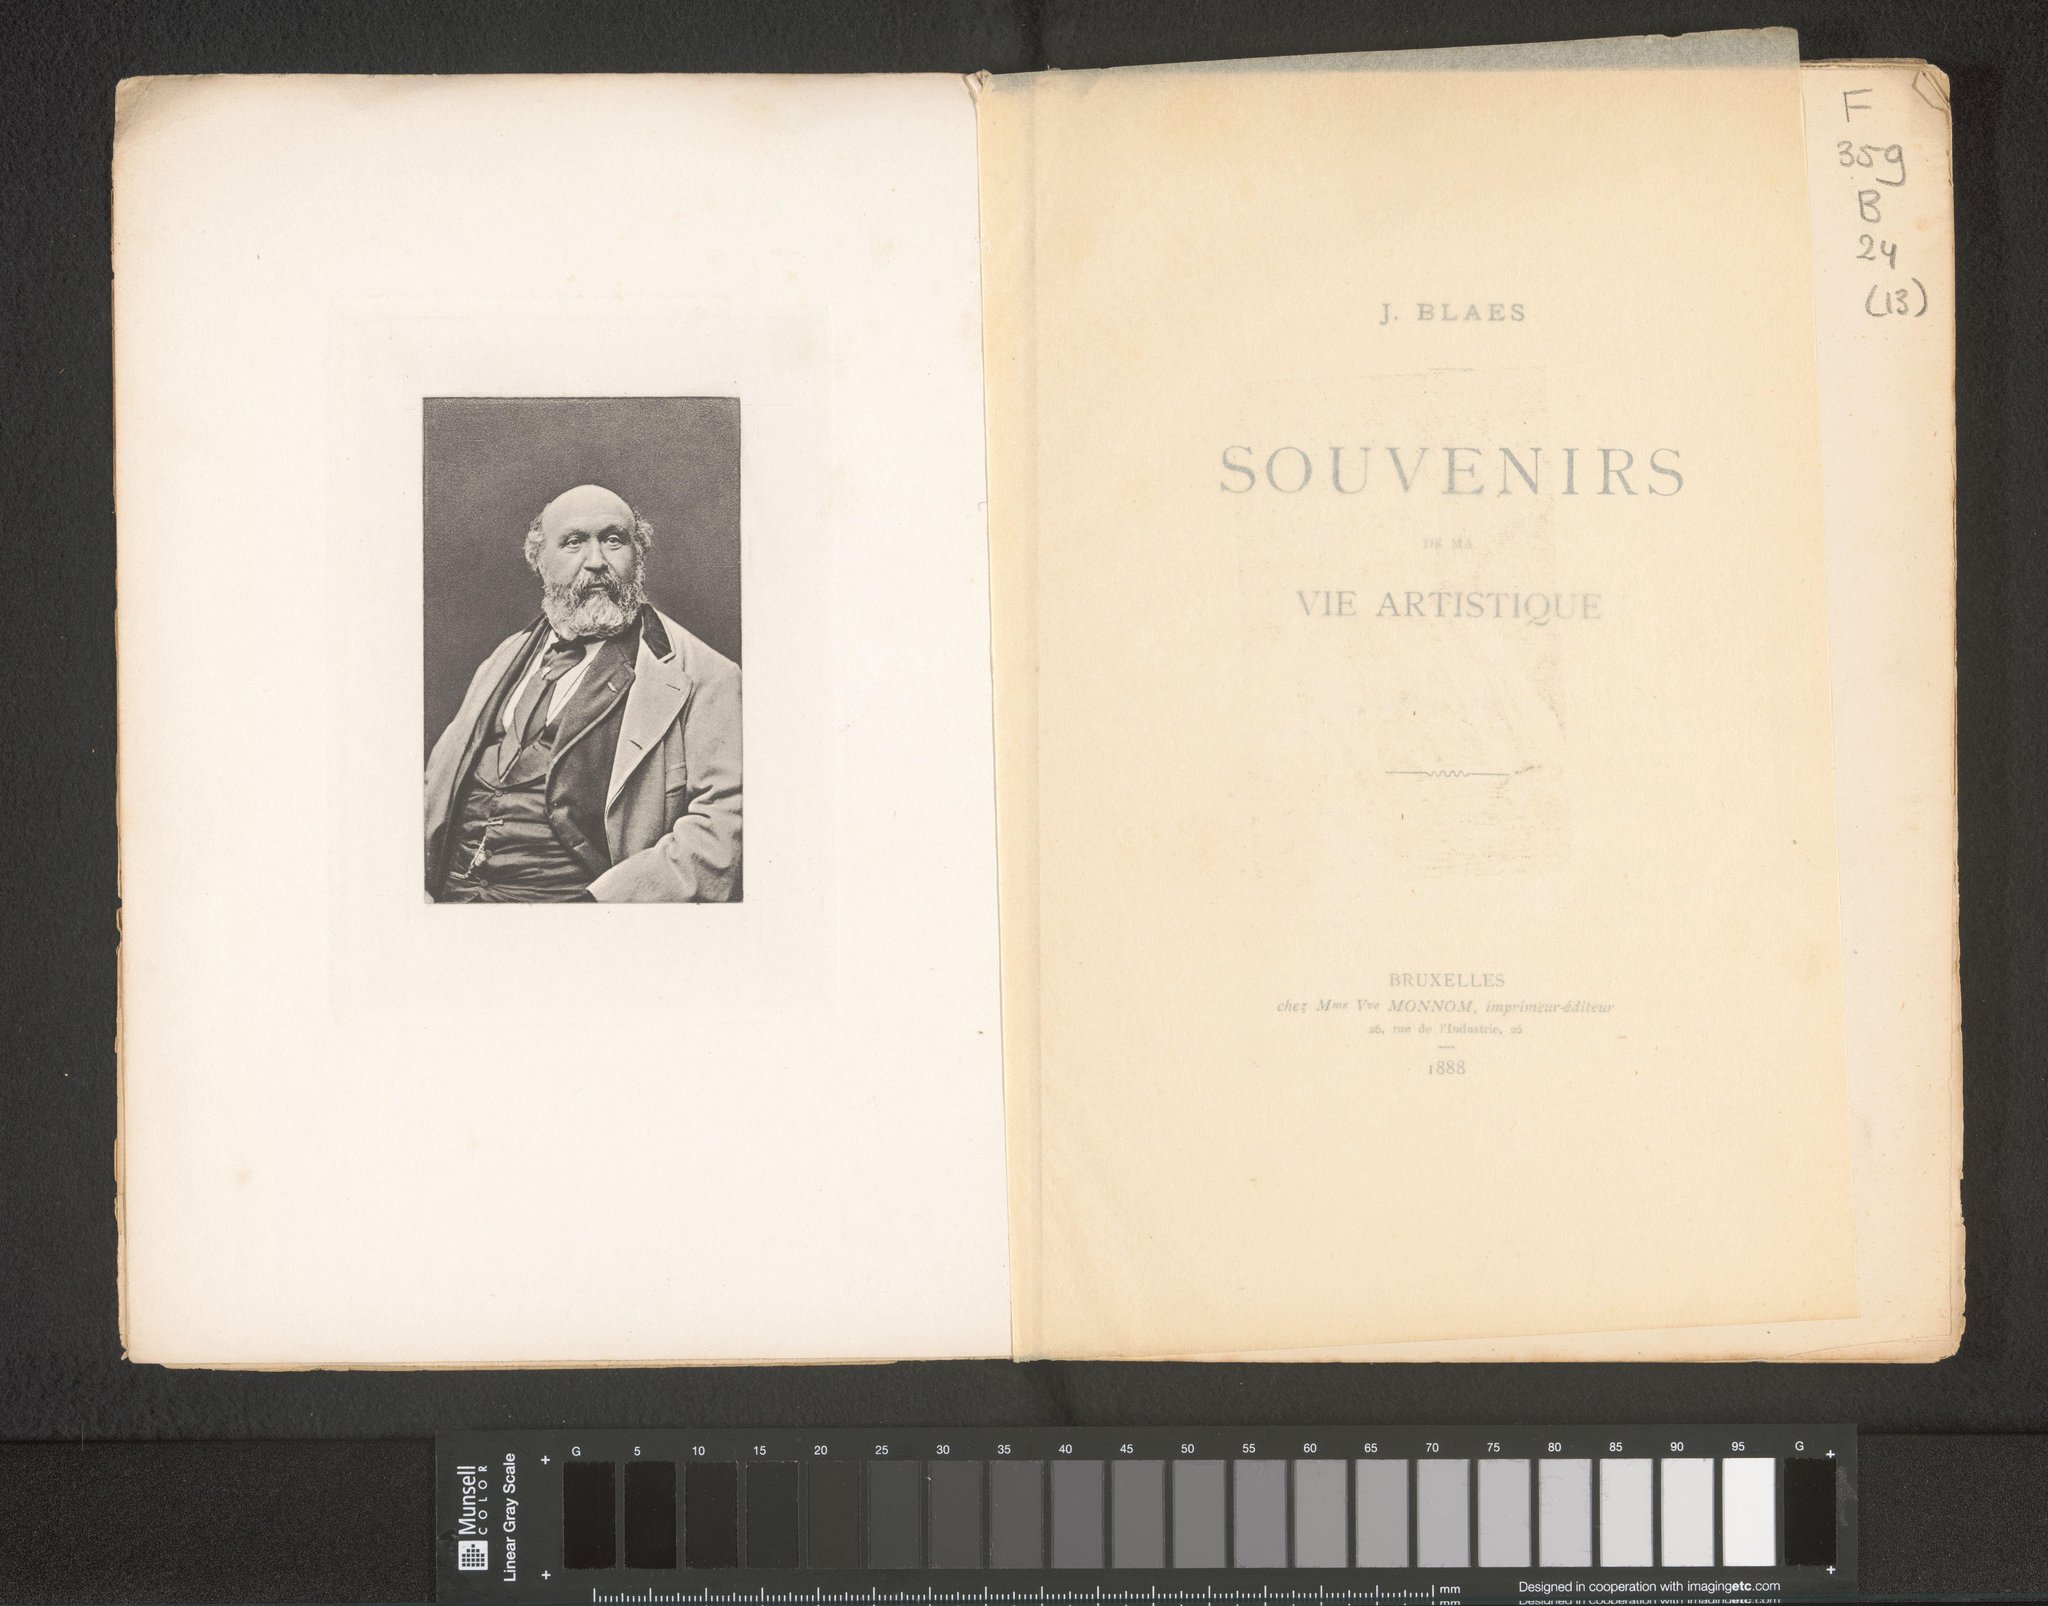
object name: page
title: Portret van een onbekende man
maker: Anonymous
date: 1883-1888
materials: paper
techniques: photoaquatint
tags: adult man, historical persons